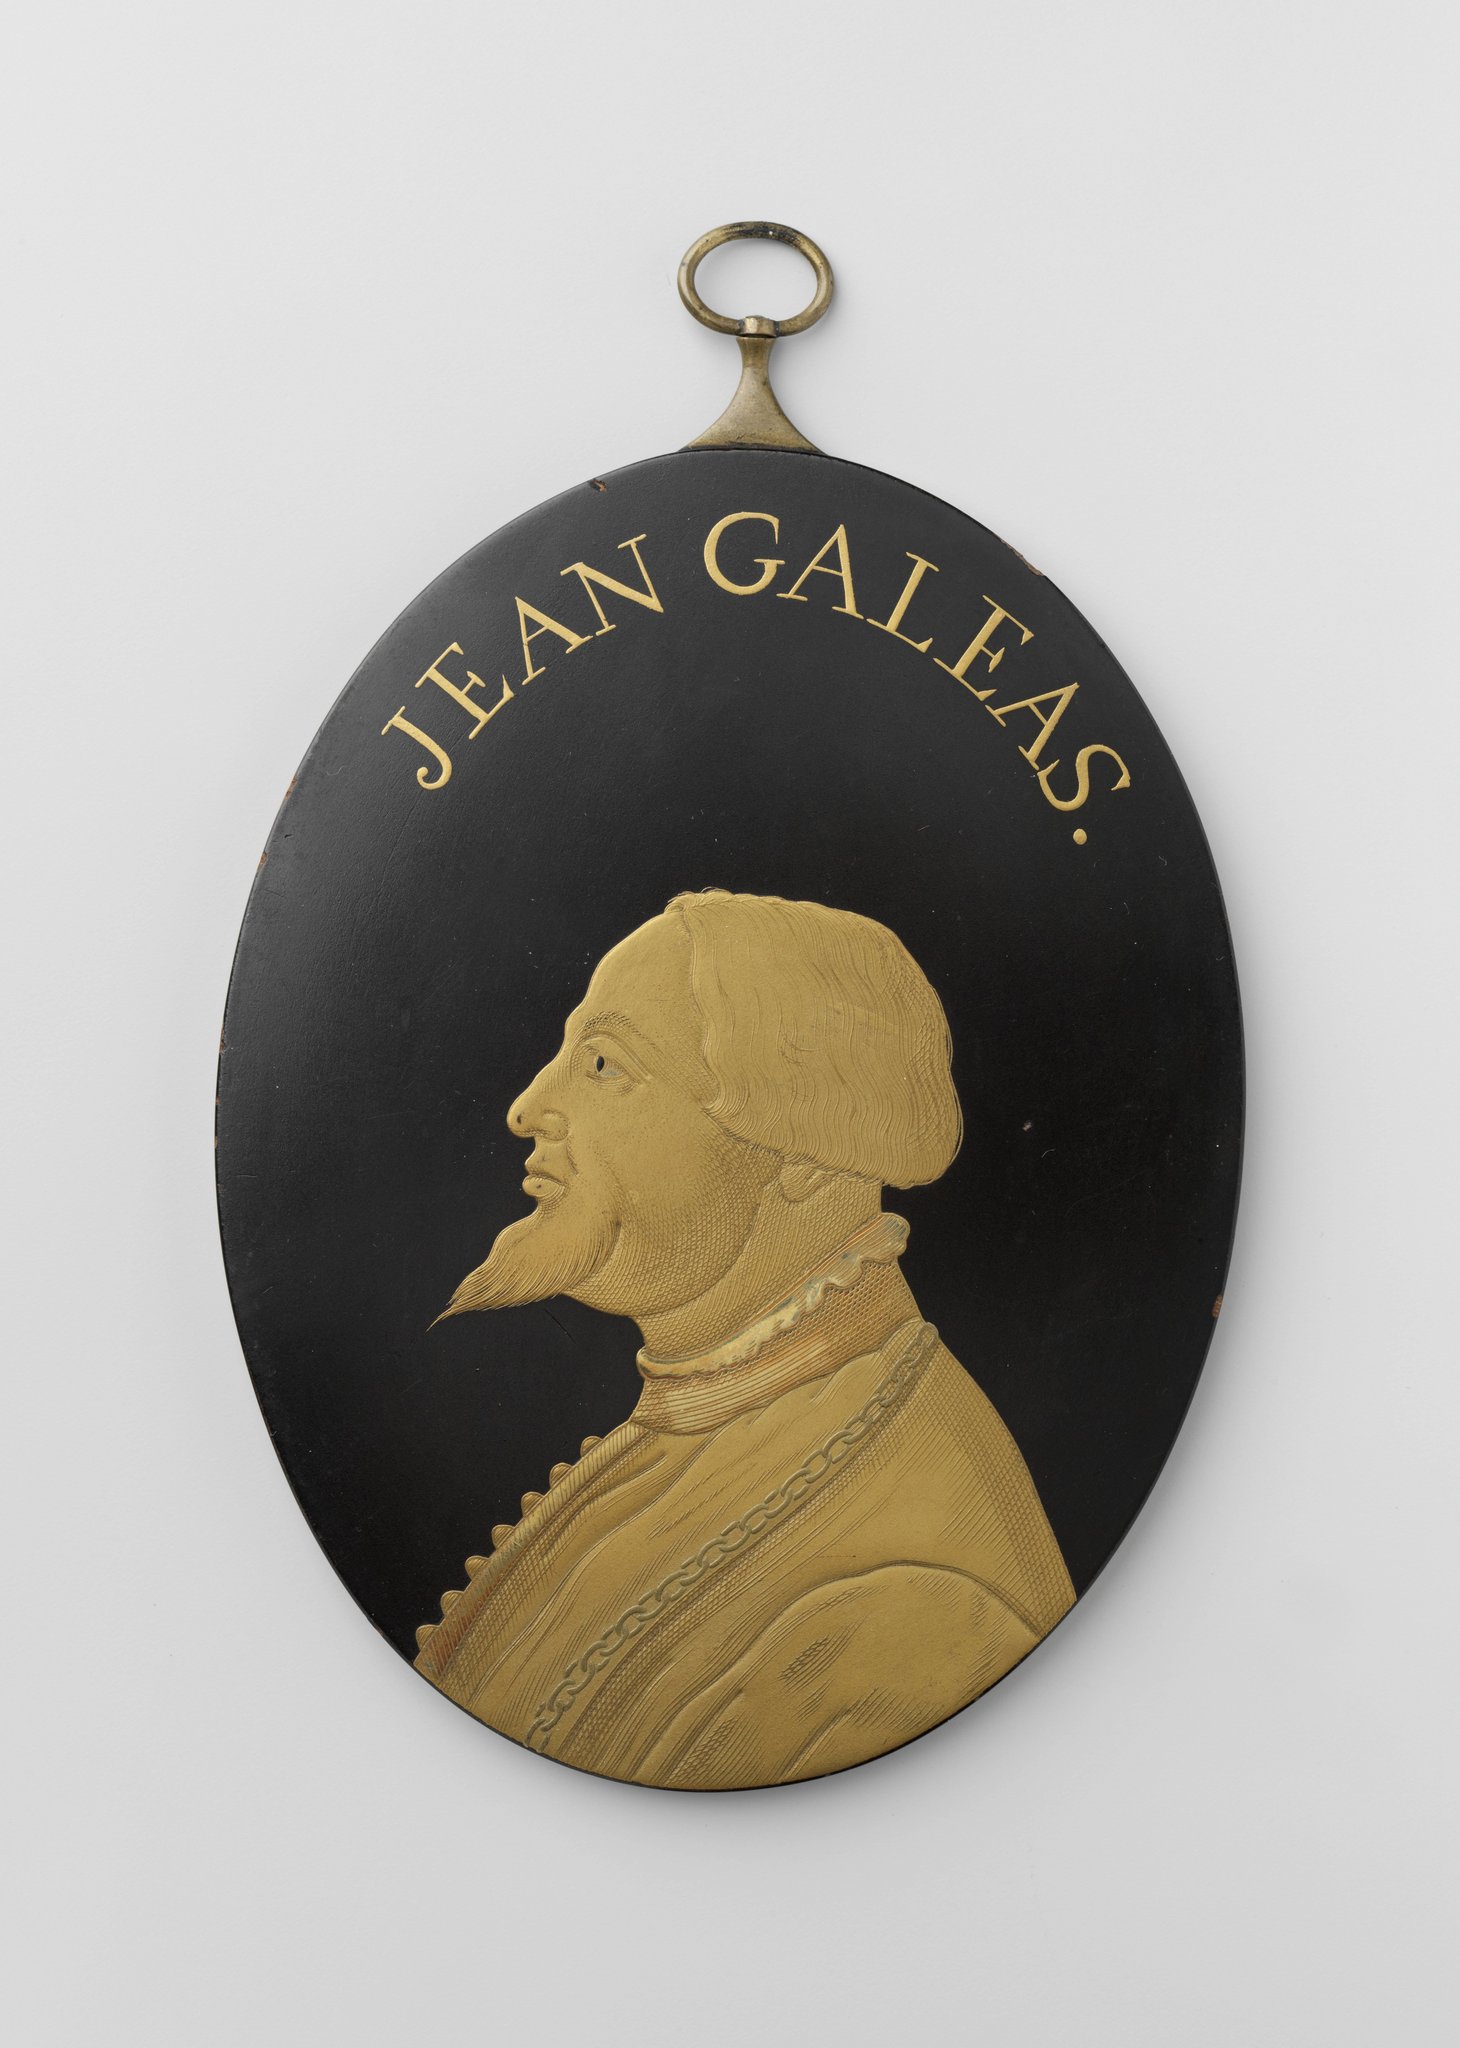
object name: plaque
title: Francoys de Scepeaulx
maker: Anonymous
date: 1775-1800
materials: copper, gold, lacquer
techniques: lacquer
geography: japan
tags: maarschalk, ambassadeur, gouverneur, diplomaat, françois de scepeaux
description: Portraits of European monarchs and scholars. Japan, last quarter 18th century. The VOC exported lacquer products commissioned specifically for the European market. Working from European prints, Japanese craftsmen made series of portraits for the VOC.